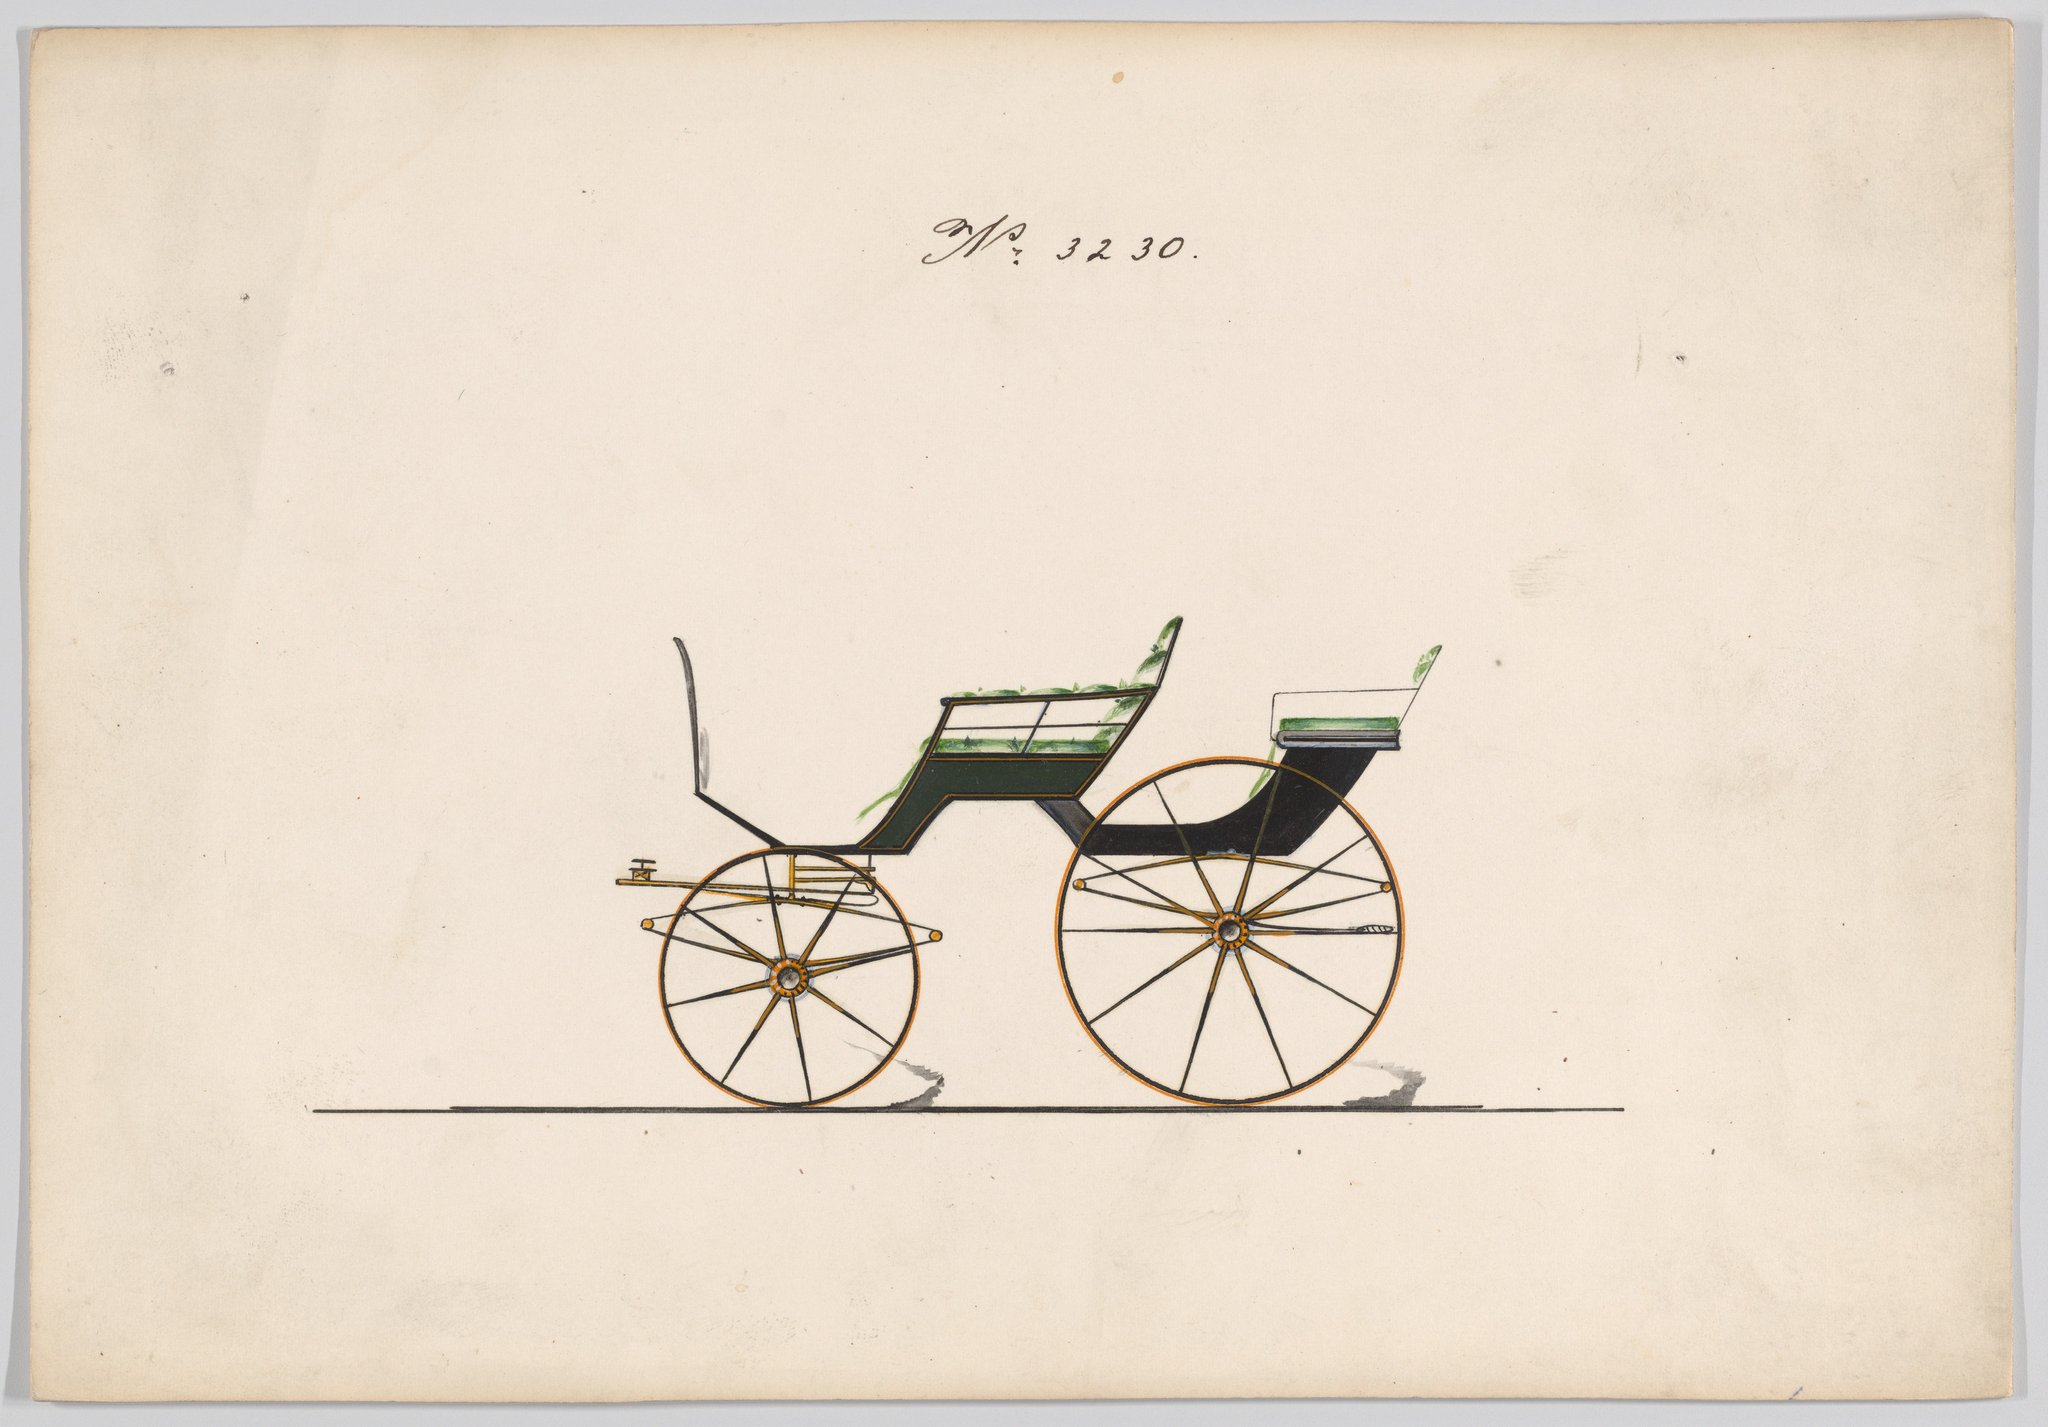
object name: drawing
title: Design for Pony Phaeton, no. 3230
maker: brewster & co.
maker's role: manufacturer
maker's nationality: american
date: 1876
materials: gouache, gum arabic, ink, watercolor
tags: carriages